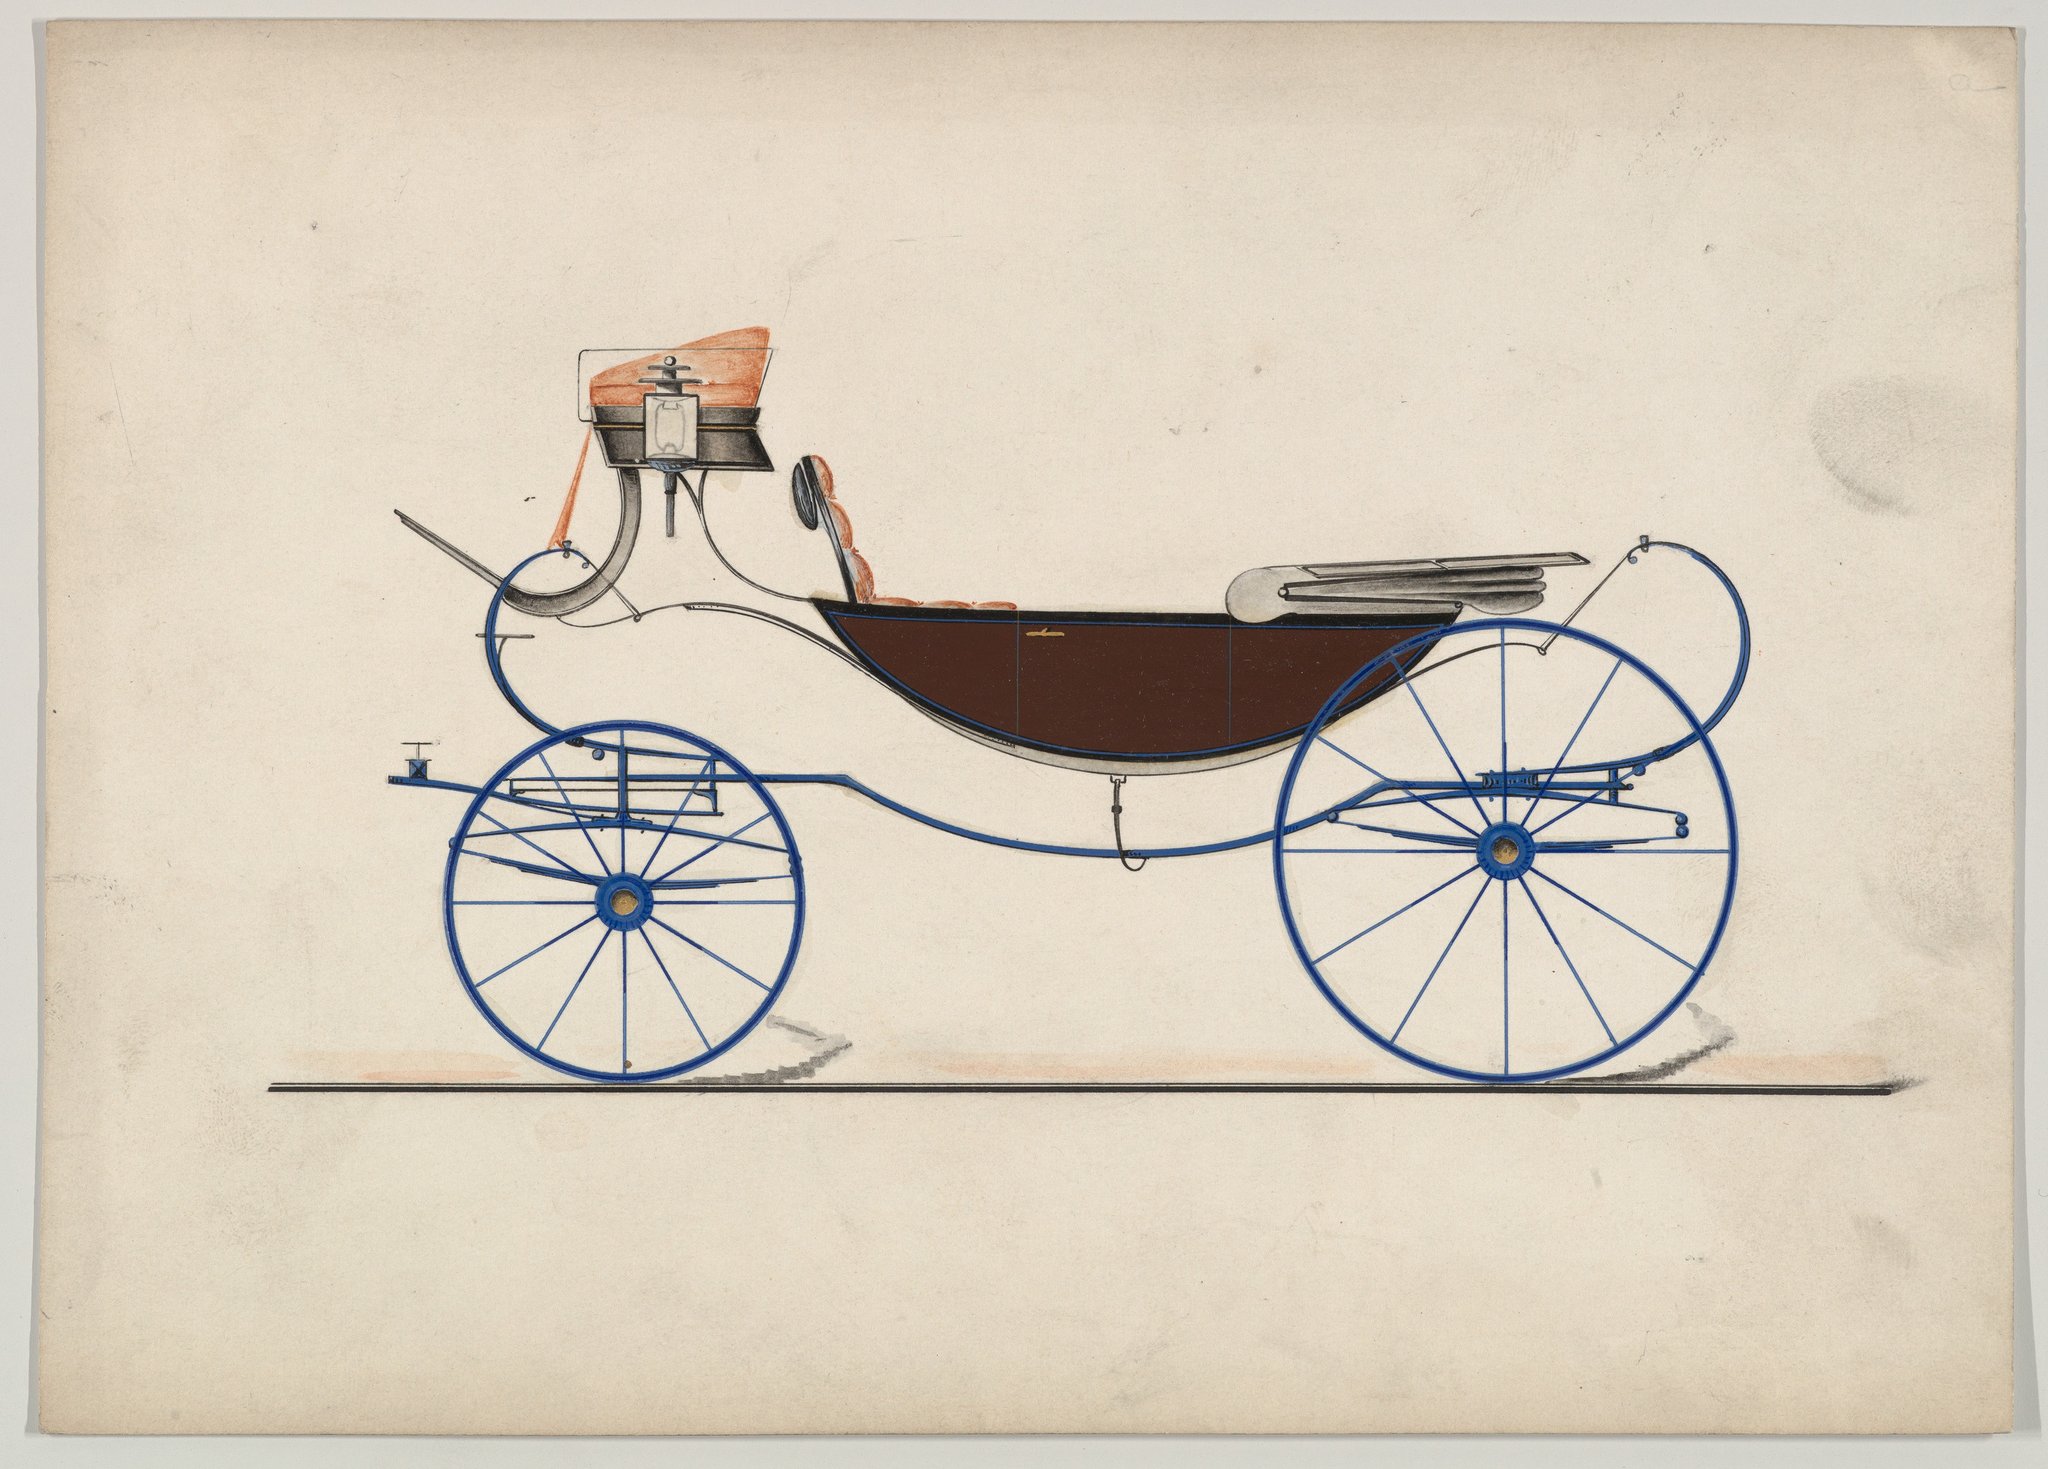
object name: drawing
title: Caleche (unnumbered)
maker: brewster & co.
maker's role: manufacturer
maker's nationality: american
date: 1850-1870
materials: gouache, gum arabic, ink, watercolor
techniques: pen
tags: carriages